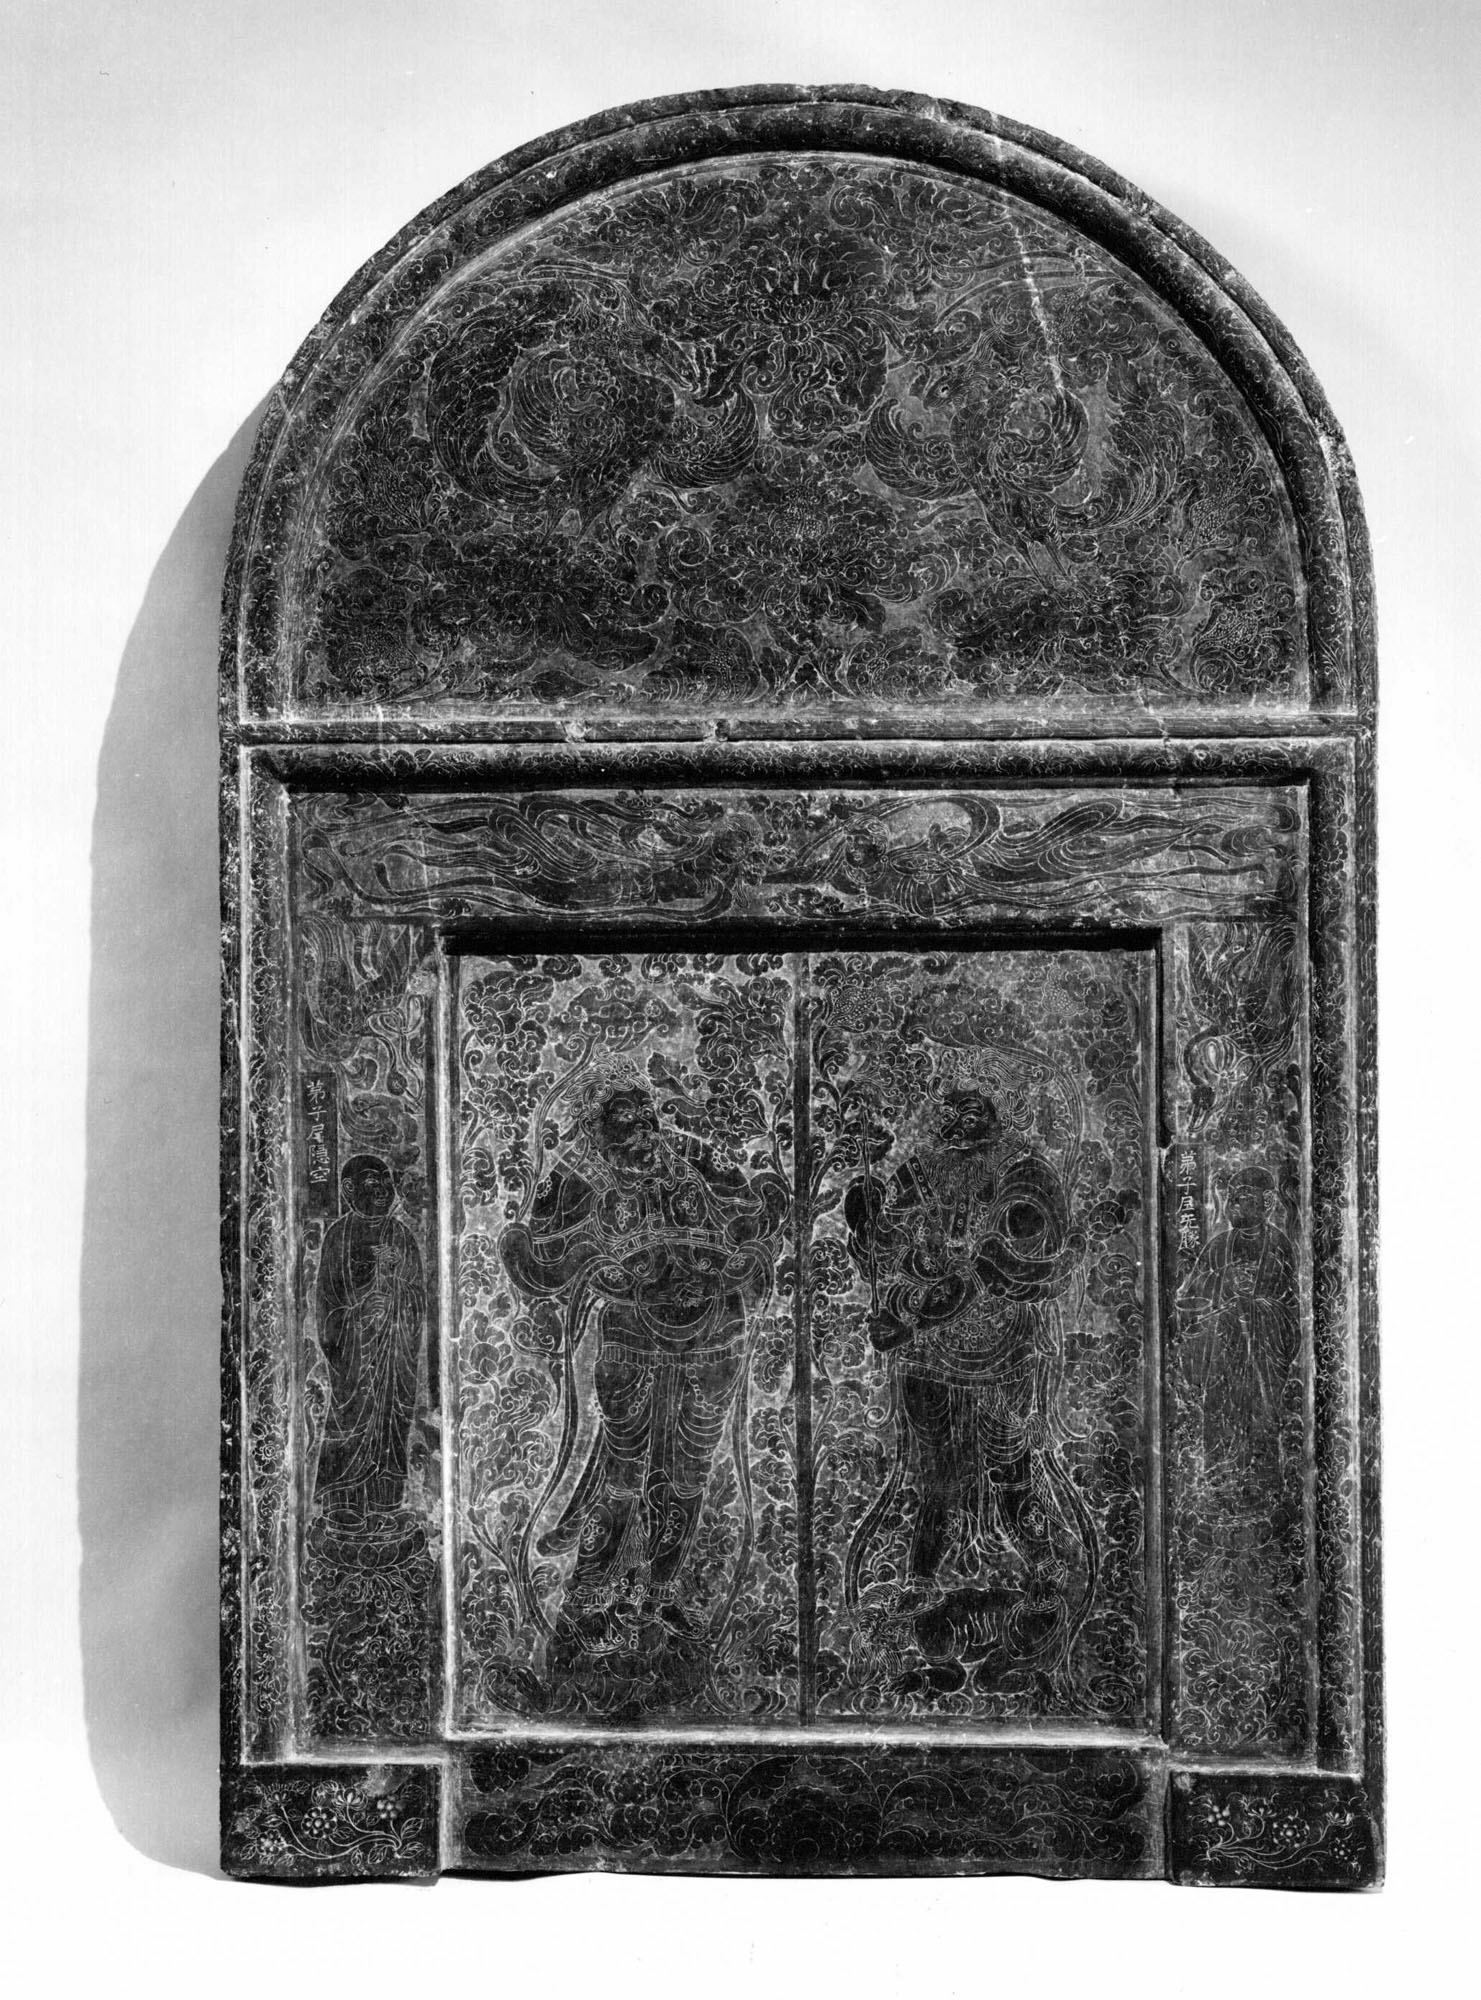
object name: panel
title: Panel in the Shape of a Sarcophagus Door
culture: chinese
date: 701-733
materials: limestone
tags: men,phoenix